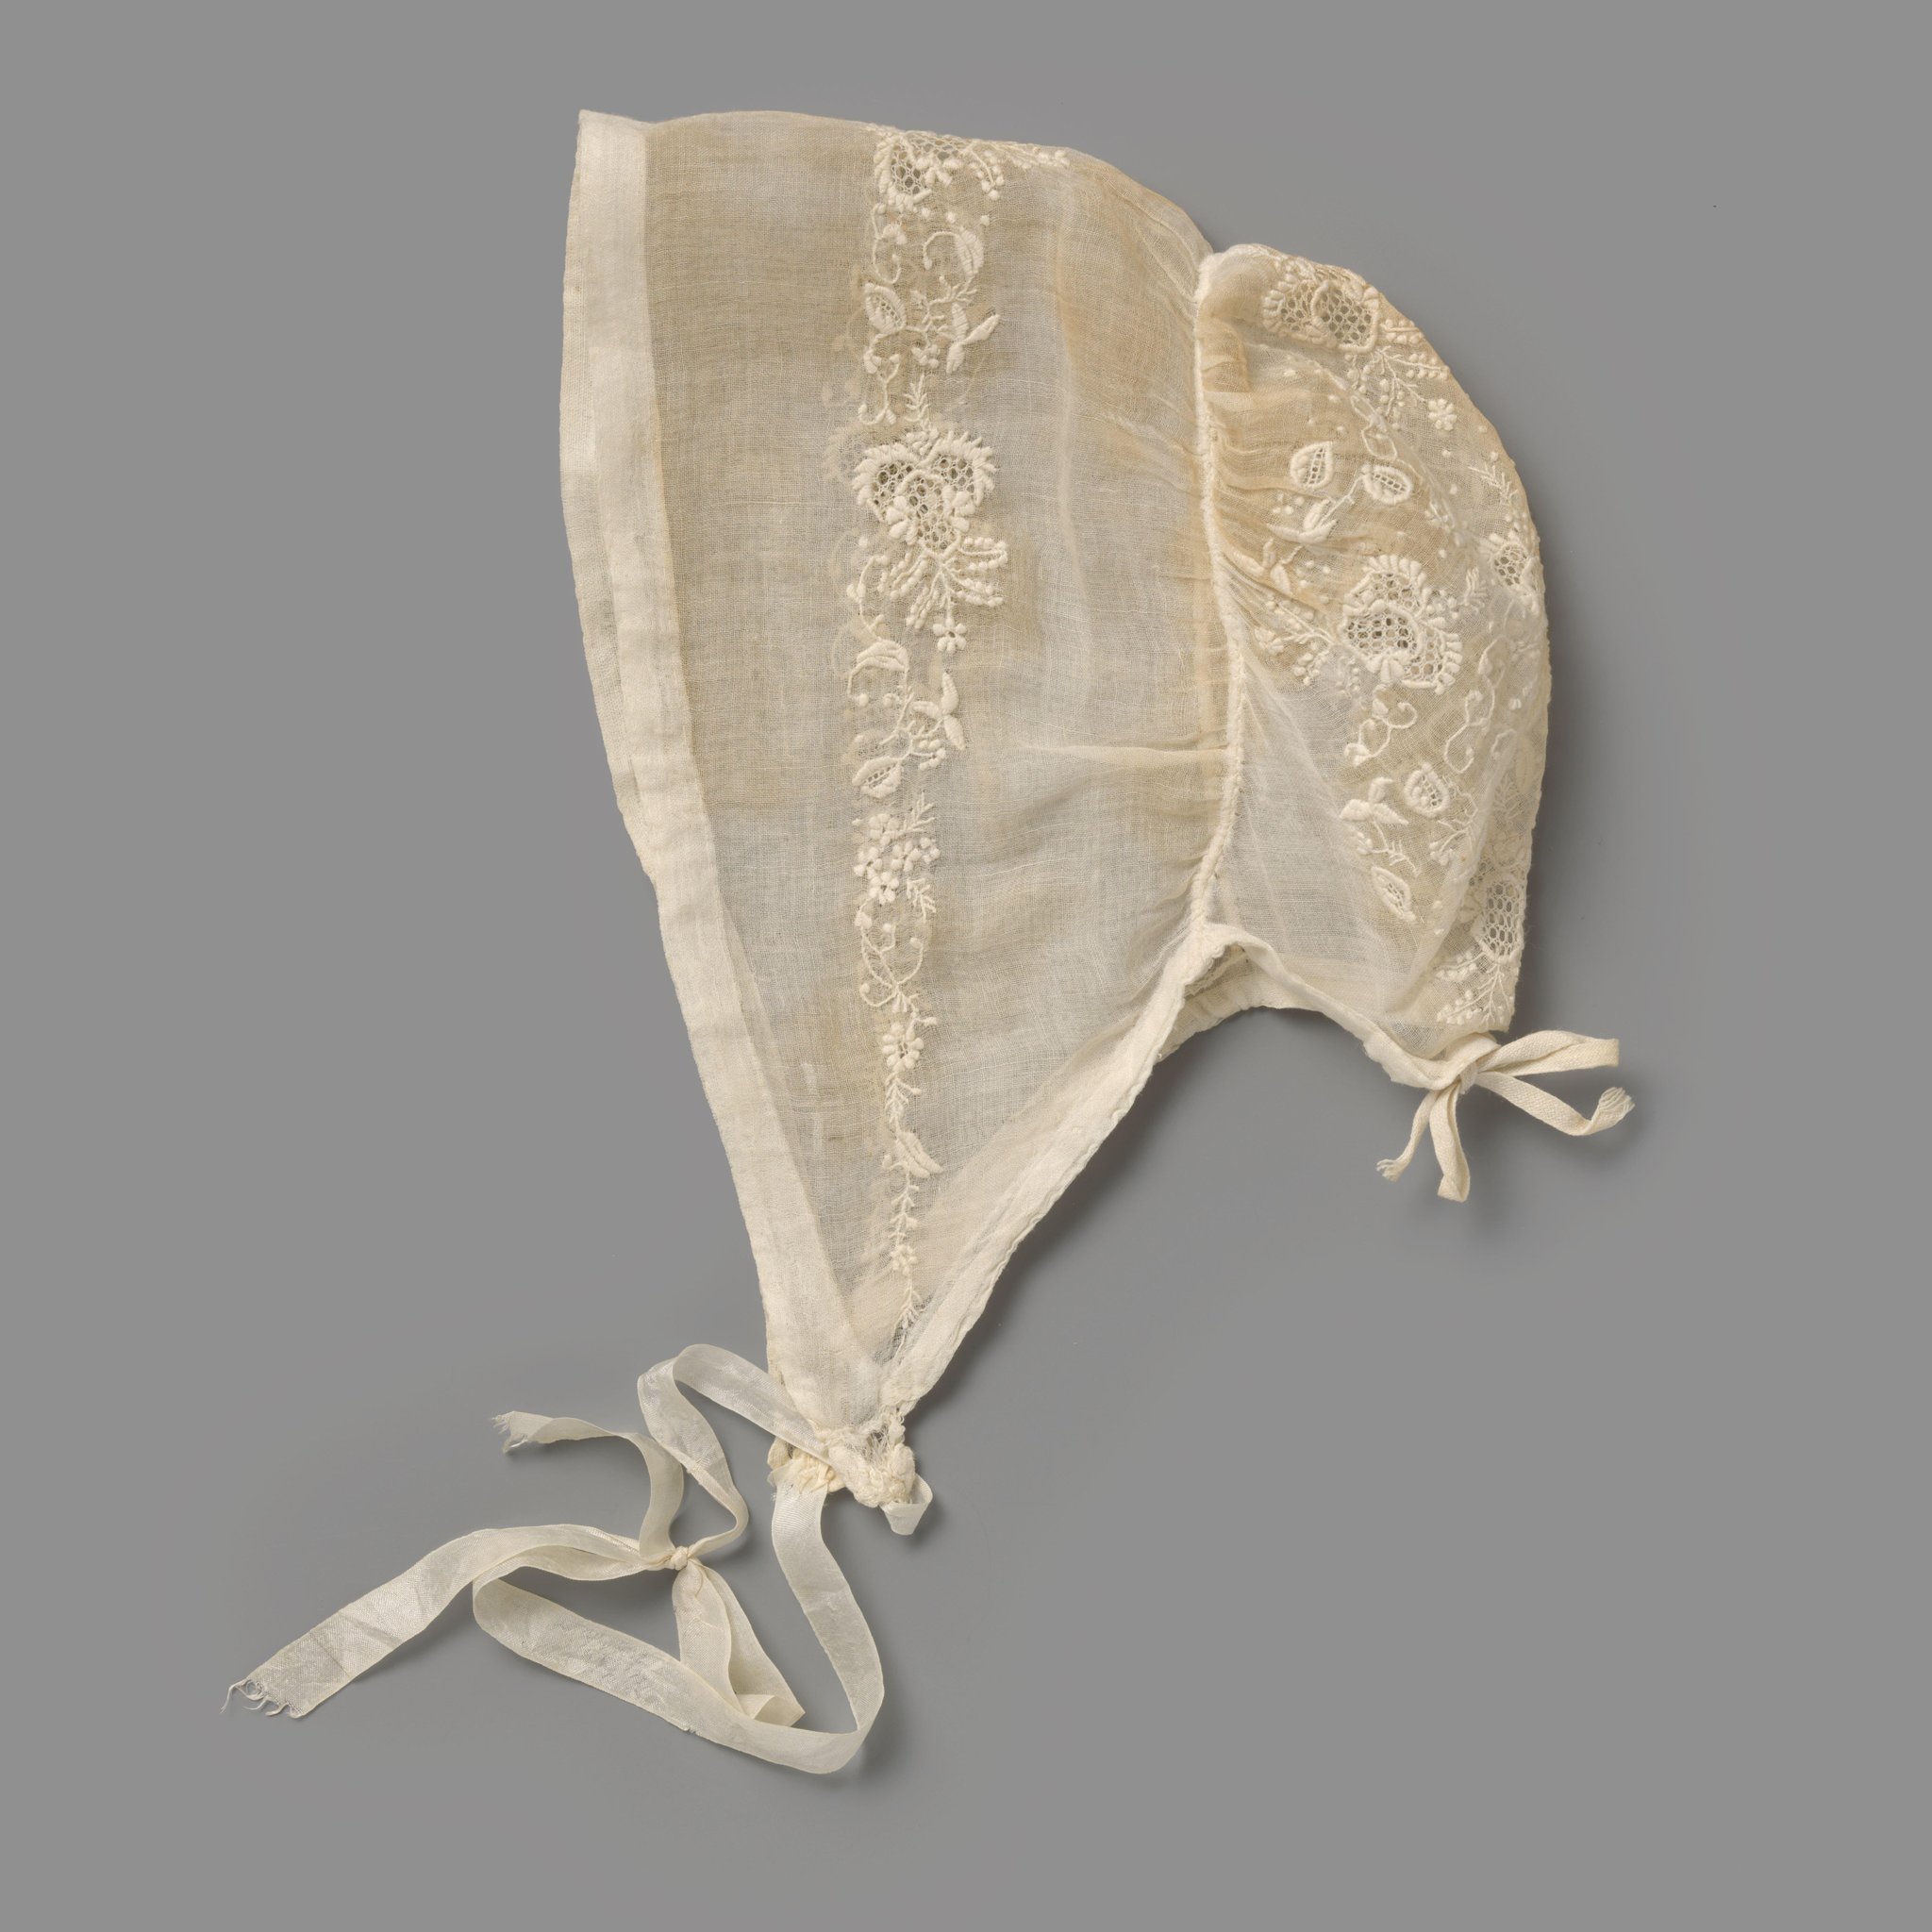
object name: childrenswear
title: Kindermuts van batist met plumetisborduurwerk; op de brede luifelpas is een smalle rand van drie opengewerkte fils tirés-bladeren, waartussen fijn rankenwerk, aangebracht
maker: Anonymous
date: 1830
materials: textile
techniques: cockled, embroidered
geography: netherlands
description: Kindermutsje van batist met borduursel. Model. Met een luifel en een ingerimpelde hoefijzerbol. Aan de luifelspanden zijn zijden lintjes aangesnaaid. Borduursel. Plumetisborduurwerk. Op de brede luifelpas een smalle rand van drie opengewerkte ''fils-tirés"-bladeren, waartussen fijn rankenwerk.